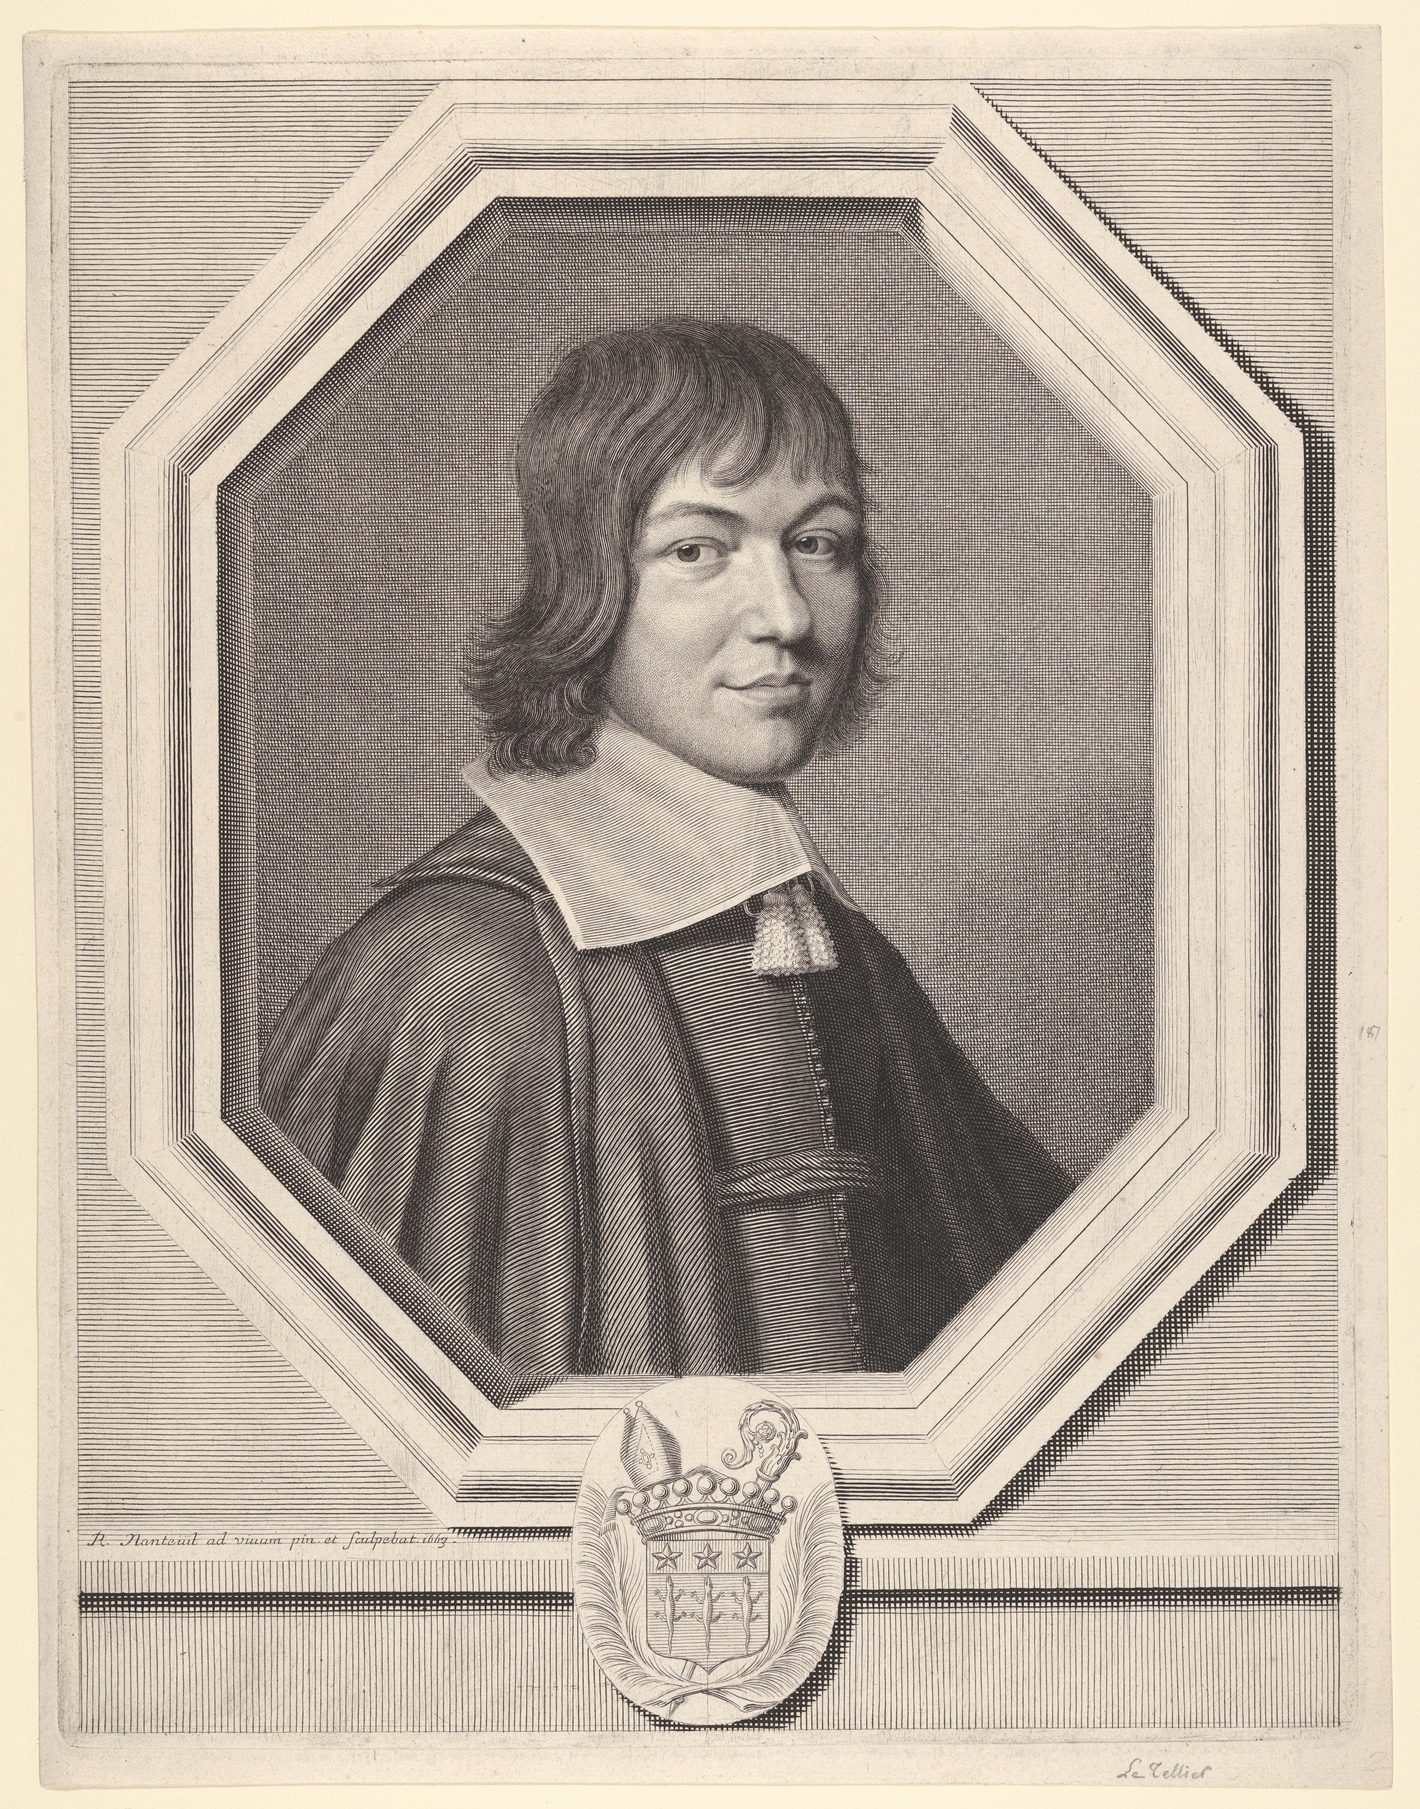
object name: print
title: Charles-Maurice Le Tellier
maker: robert nanteuil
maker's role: artist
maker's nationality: french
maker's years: 1623-1678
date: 1663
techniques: engraving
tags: men,portraits